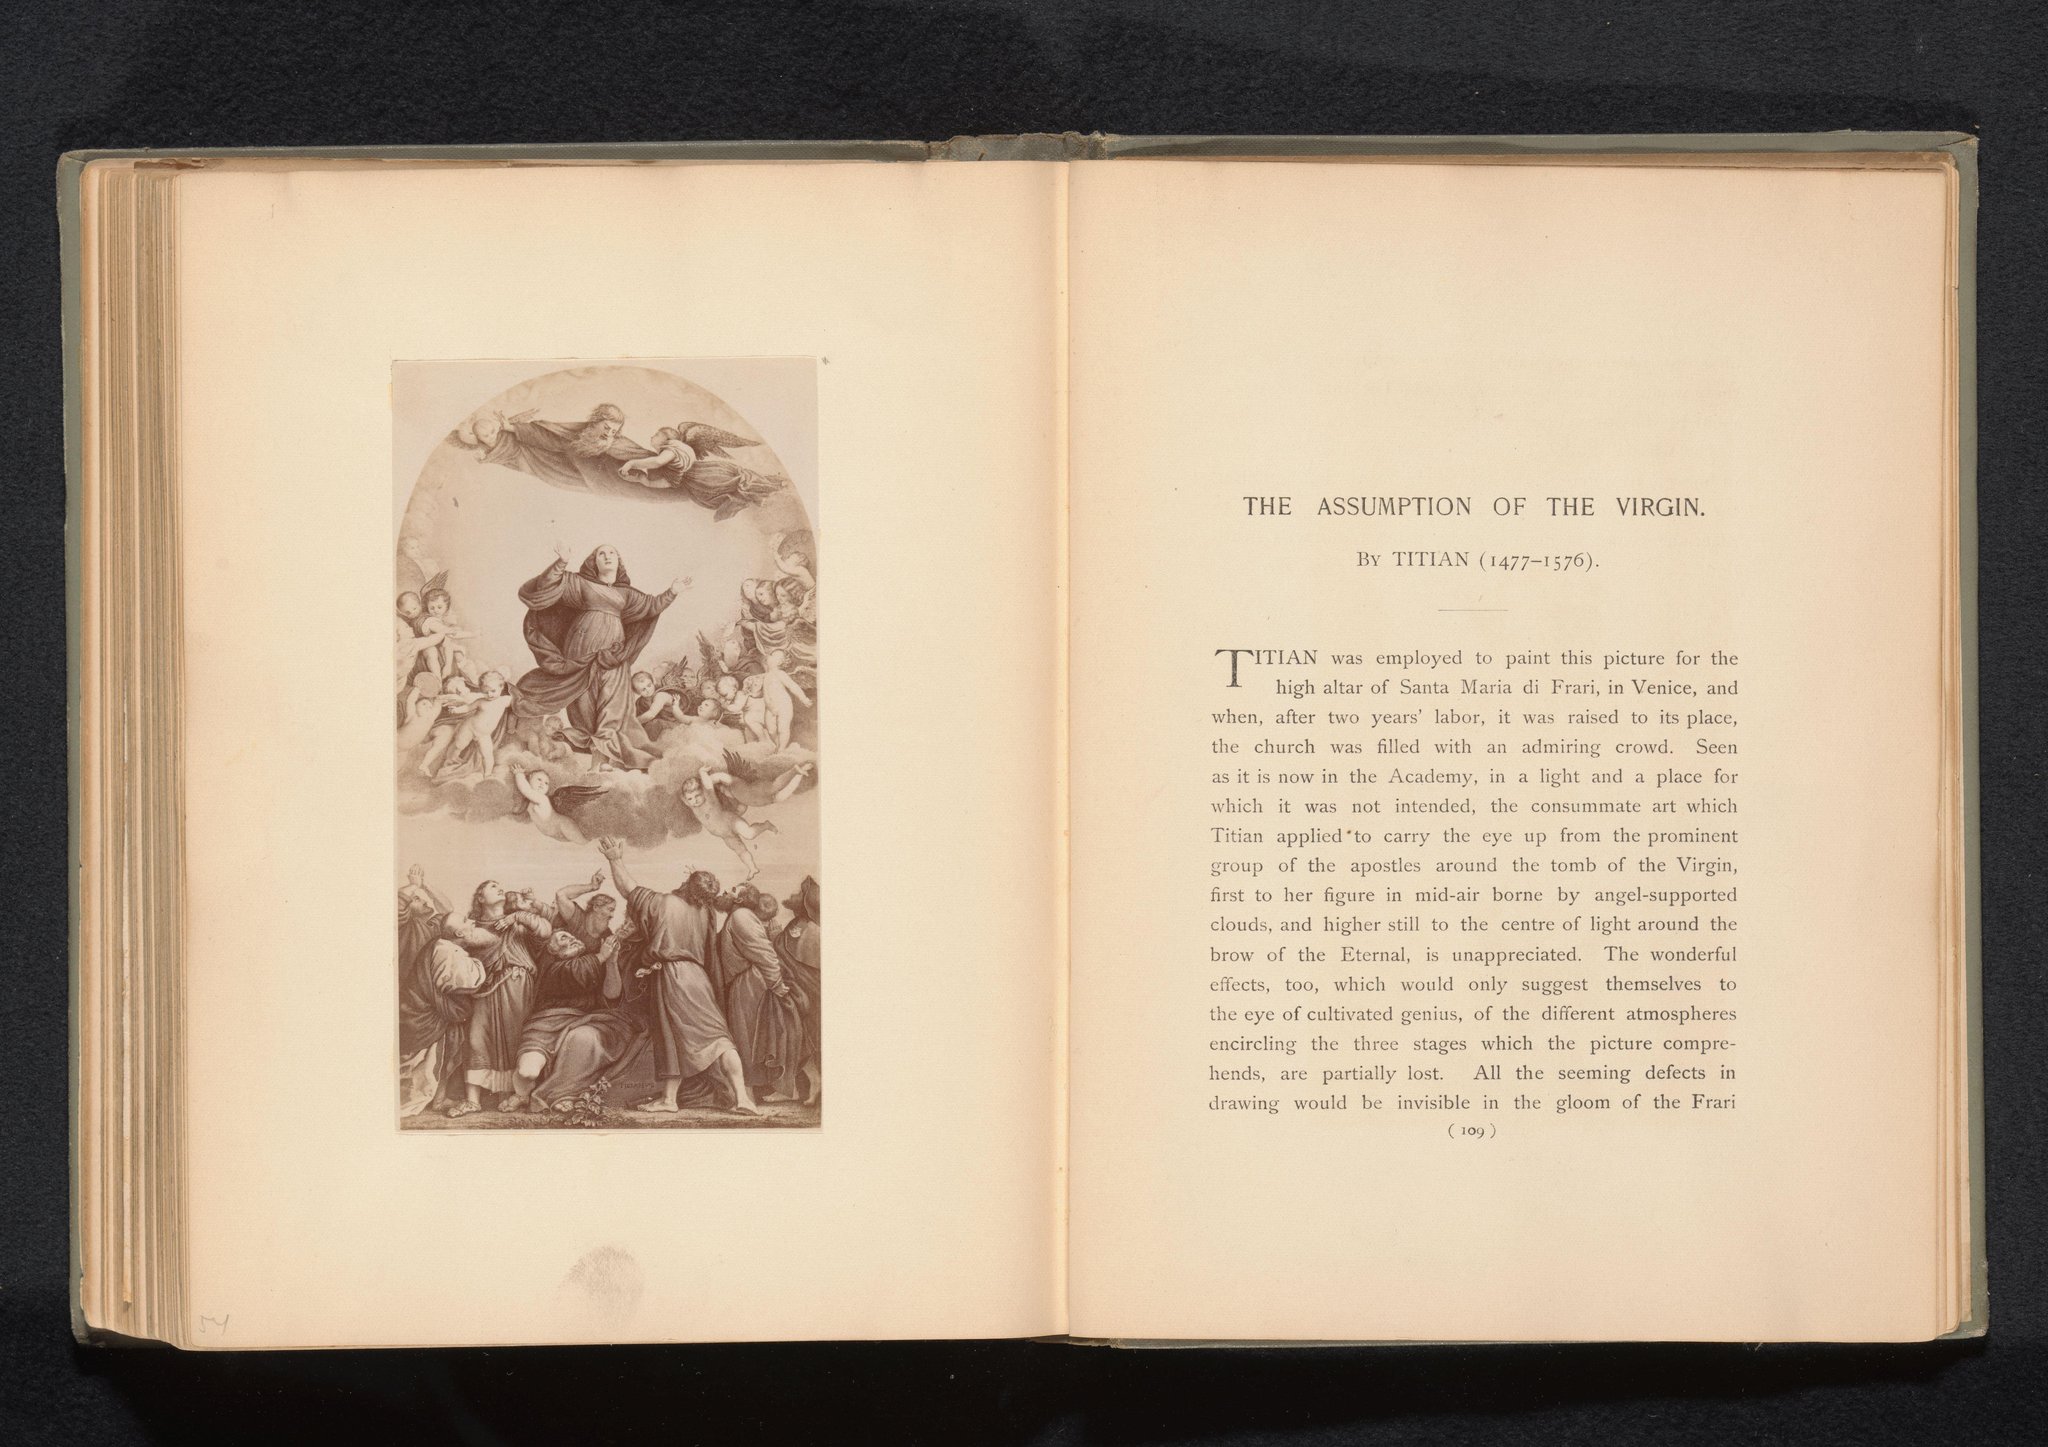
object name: photograph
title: Fotoreproductie van een prent naar een schilderij, voorstellende de hemelvaart van Maria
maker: Anonymous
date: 1882-1887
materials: photographic support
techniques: albumen print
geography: basilica di santa maria gloriosa dei frari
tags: the assumption of mary ('assumptio corporis'): she is borne into heaven by angels